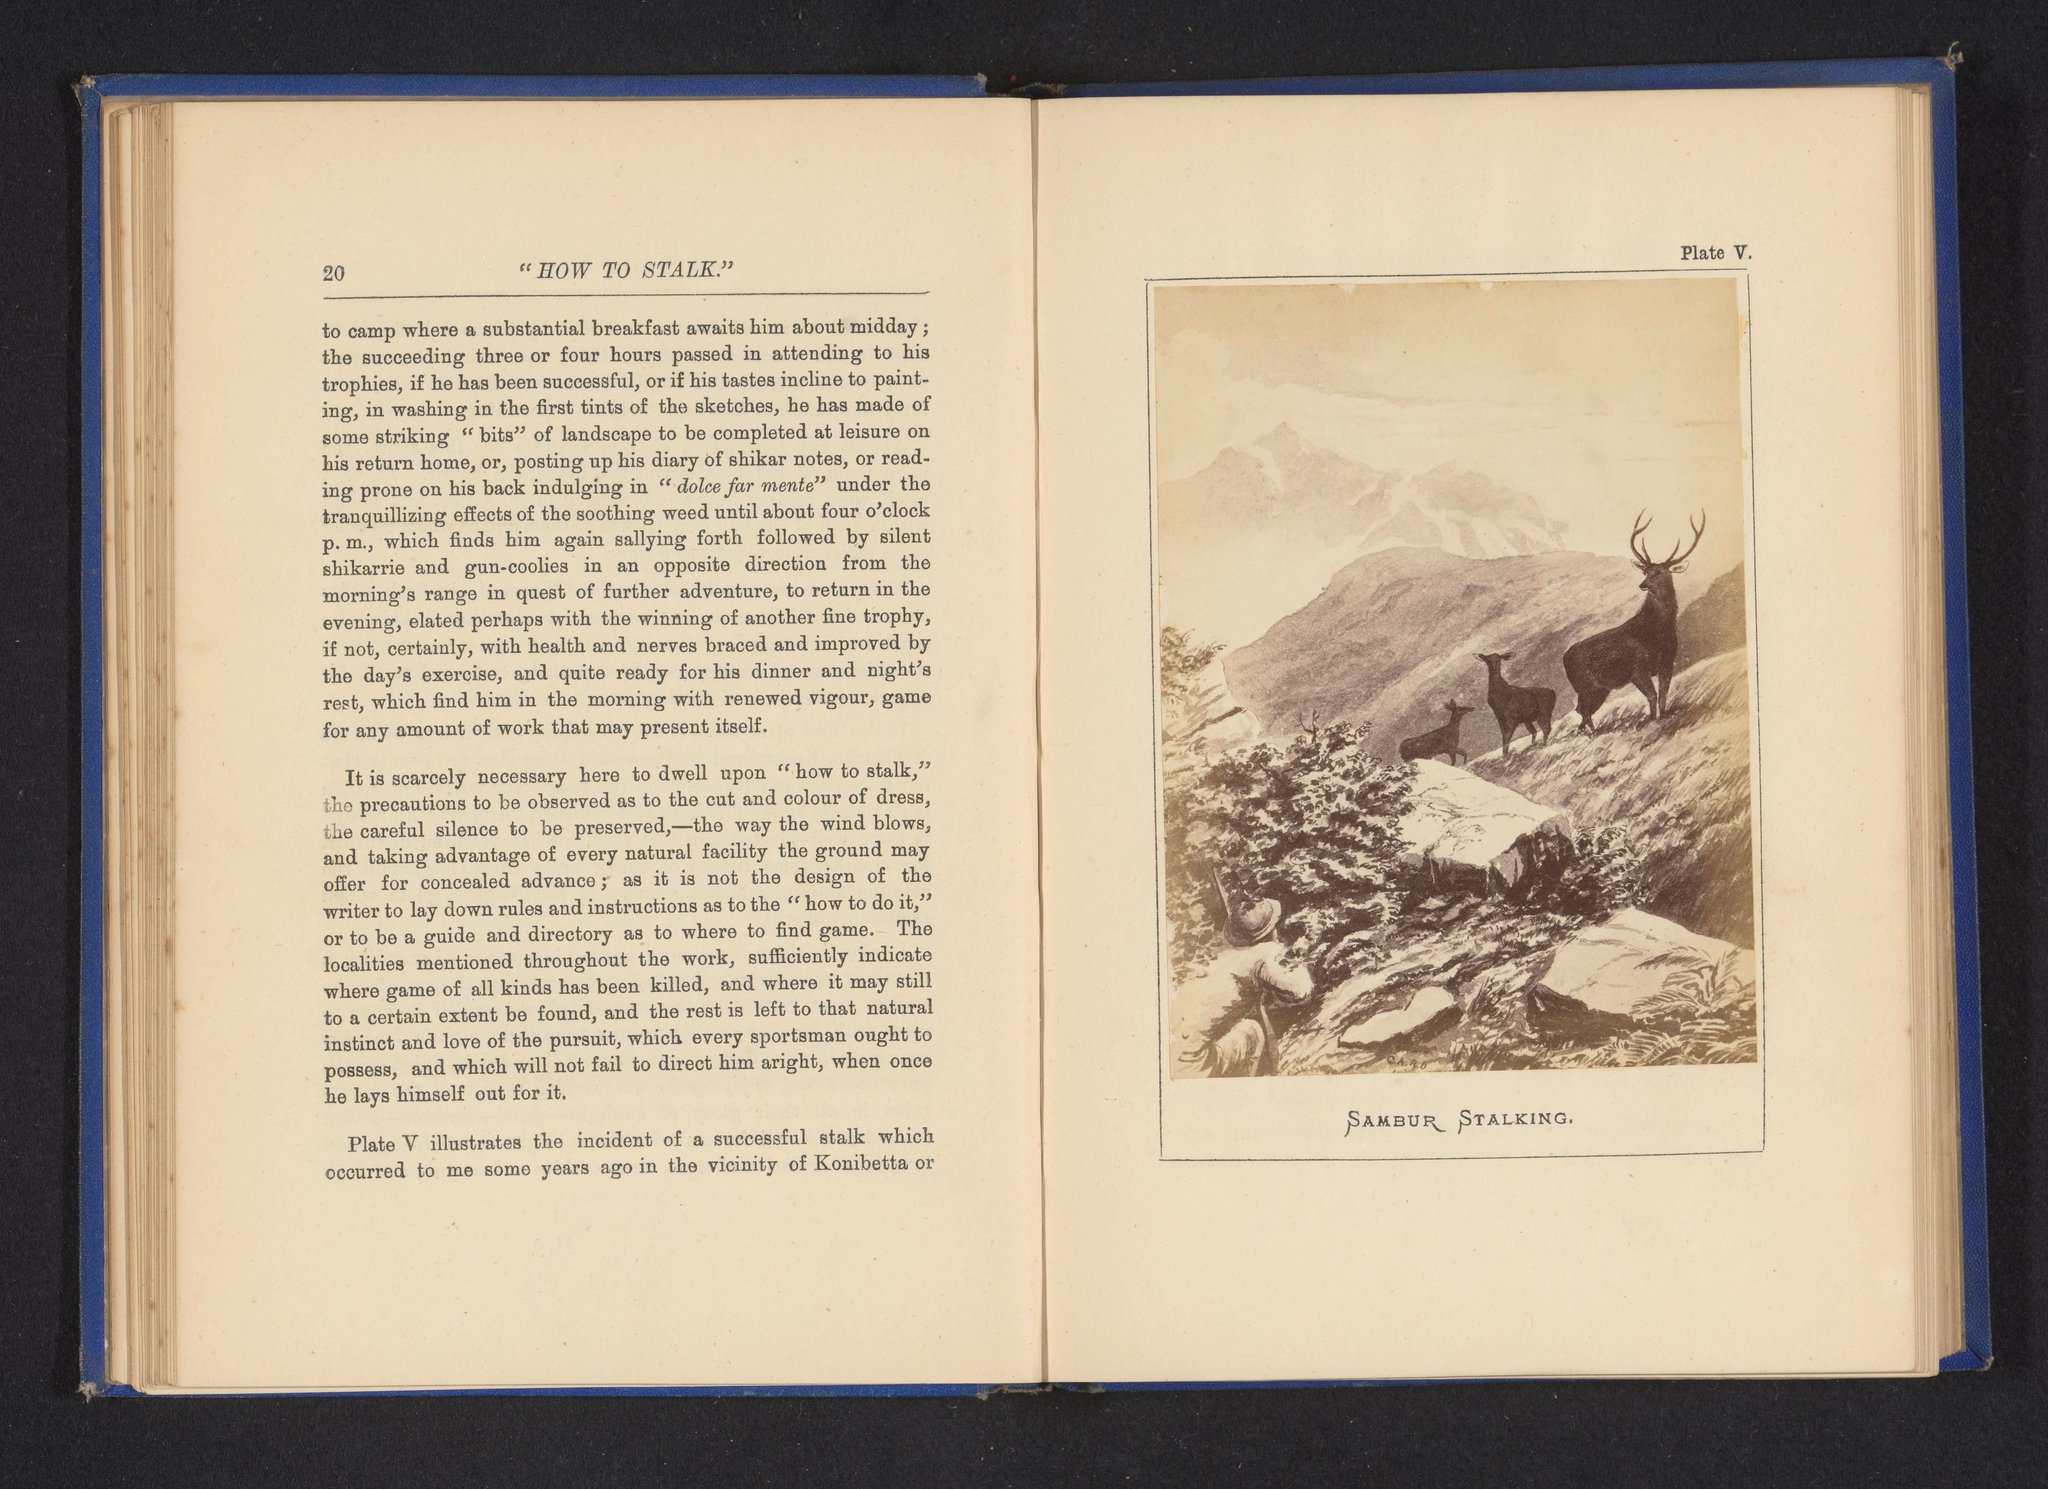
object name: page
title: Sambur stalking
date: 1870-1880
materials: photographic support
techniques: albumen print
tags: drawing, sketch, hoofed animals: deer, hunt ~ mammals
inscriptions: number: ‘Plate V.’